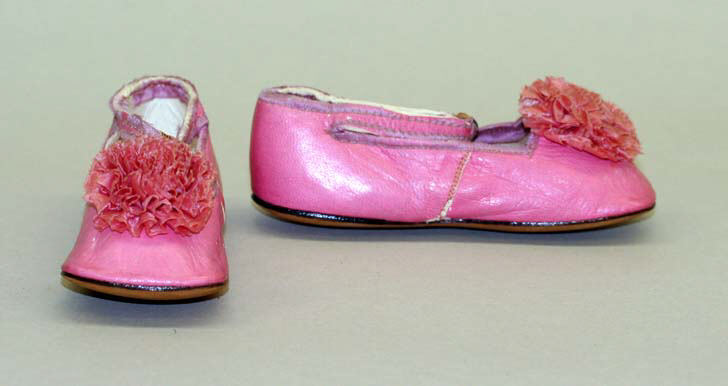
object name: shoe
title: Shoes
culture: american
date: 1834-1866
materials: leather